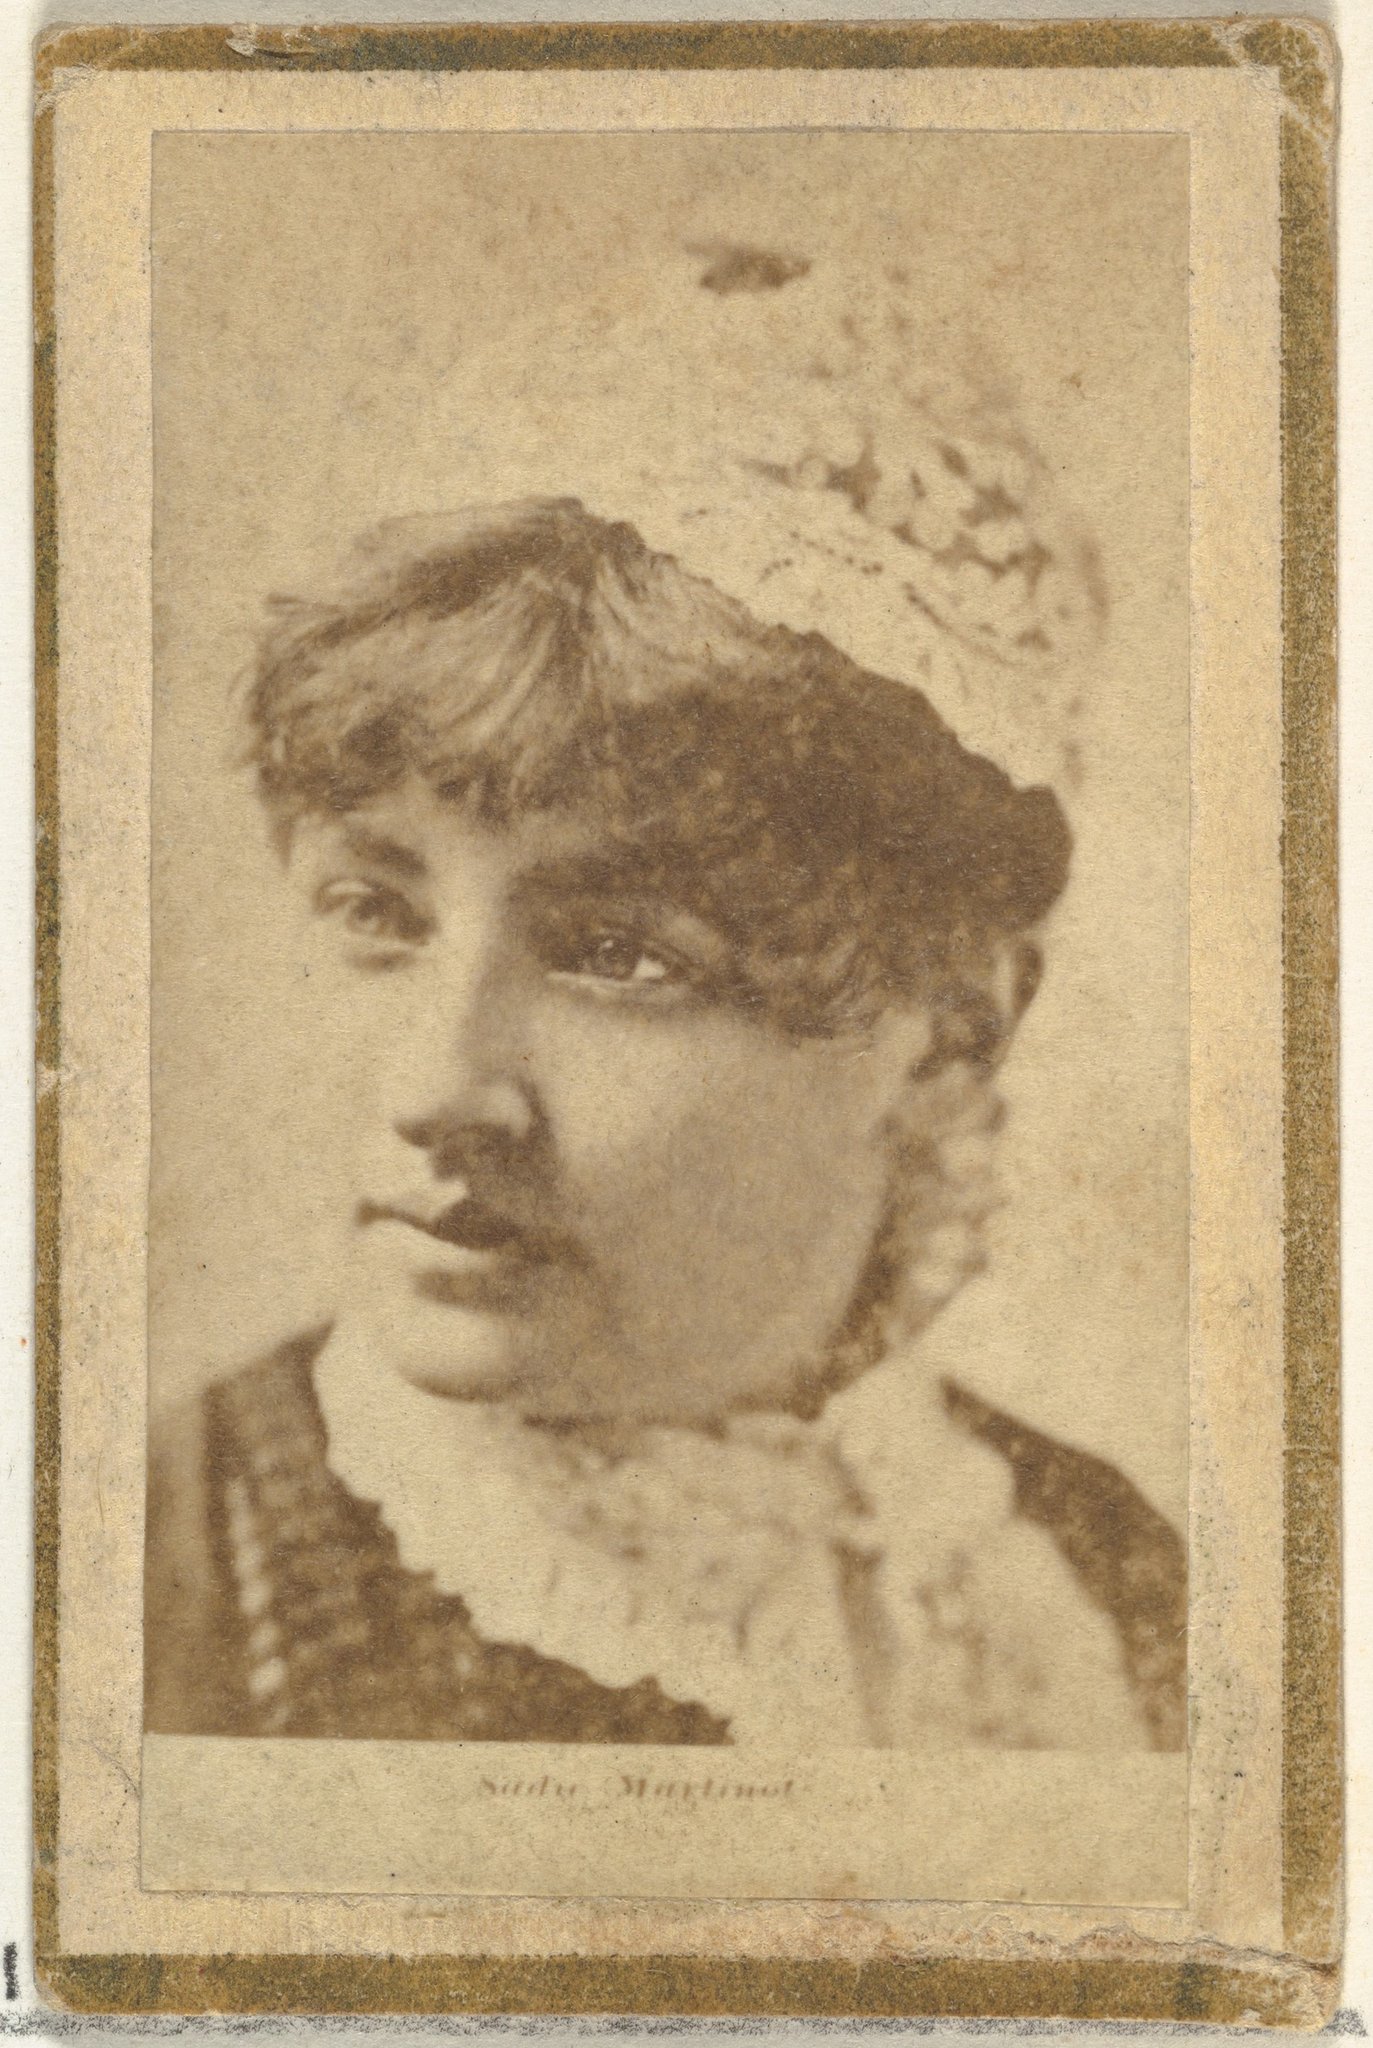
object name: photograph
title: Sadie Martinot, from the Actresses and Celebrities series (N60, Type 2) promoting Little Beauties Cigarettes for Allen & Ginter brand tobacco products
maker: allen & ginter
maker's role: publisher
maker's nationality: american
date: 1887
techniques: albumen silver print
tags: portraits,women,actresses